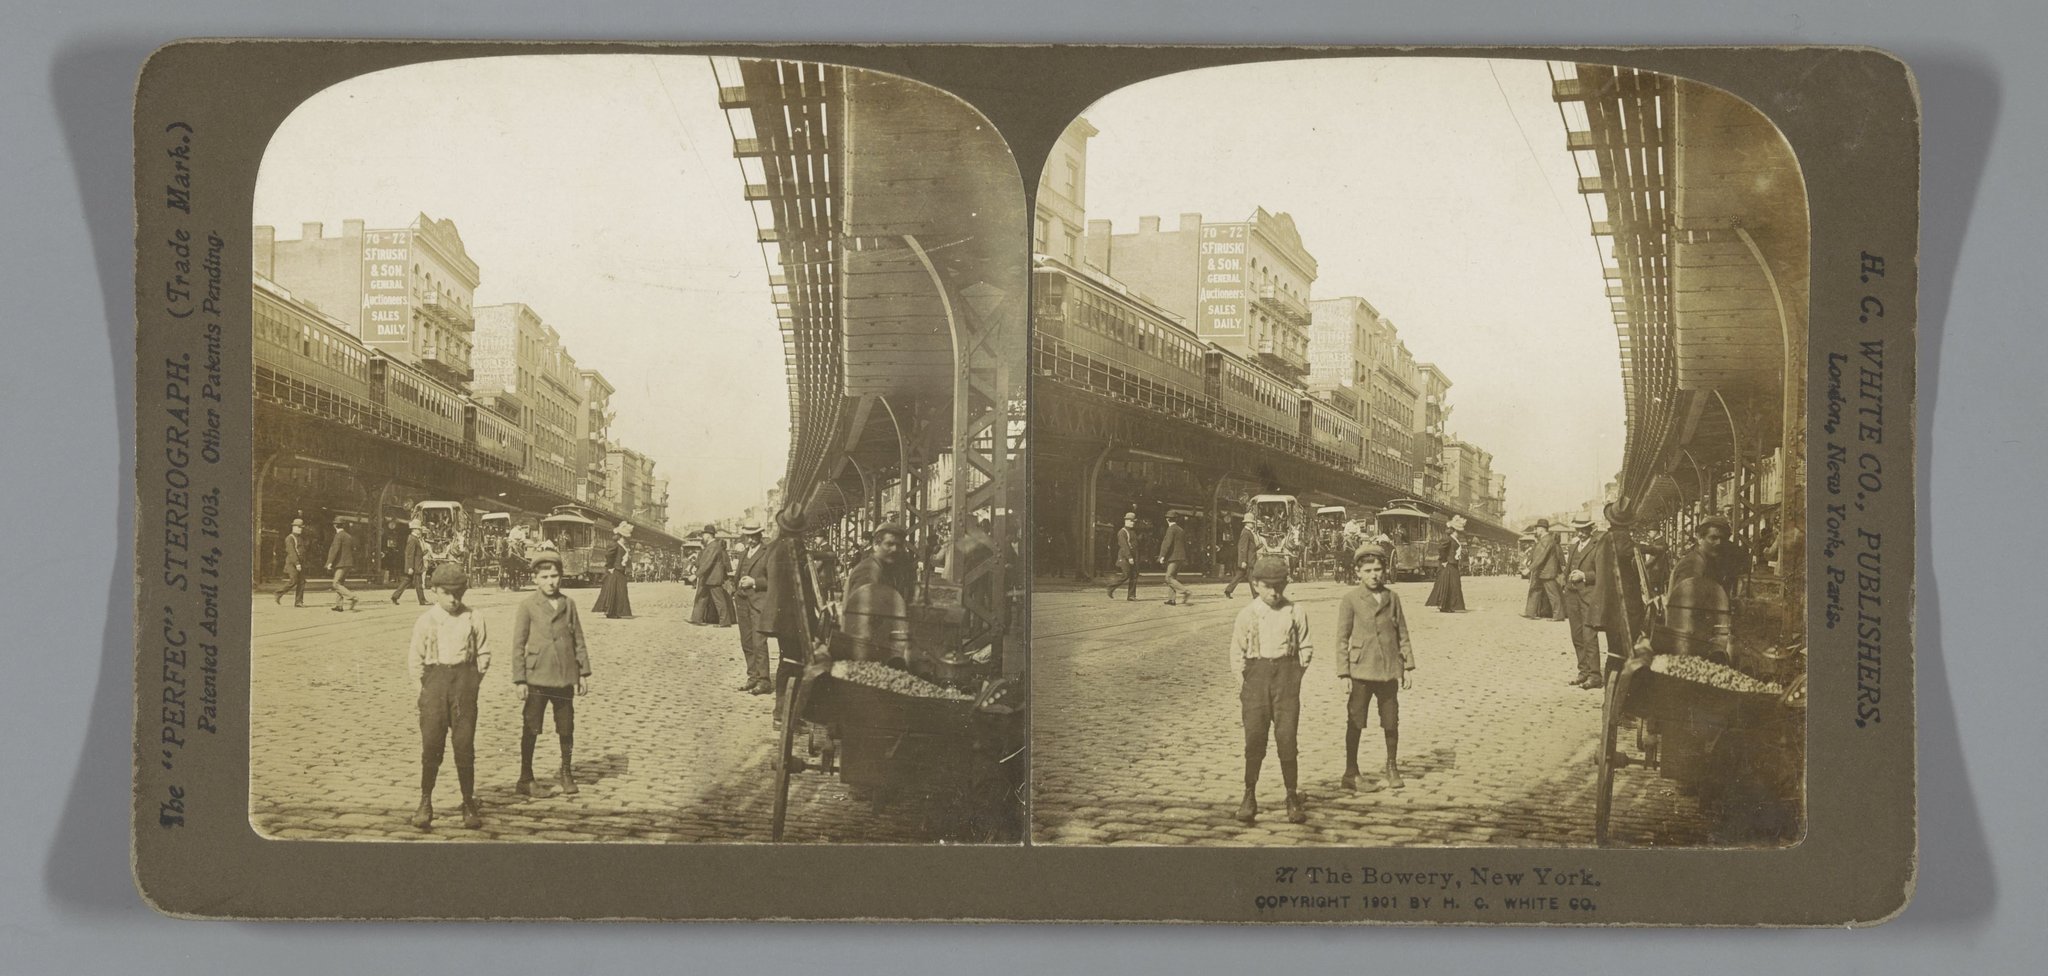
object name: stereograph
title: Bowery, New York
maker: Anonymous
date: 1901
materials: paper, cardboard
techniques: gelatin silver print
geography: new york city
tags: city-view in general; 'veduta', railway, train, new york (city)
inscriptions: number: ‘27’, inscription: ‘The " PERFEC" STEREOGRAPH. (Trade Mark.)/ Patented April 14, 1903. Other Patents Pending.’, copyright notice: ‘Copyright 1901 by H. C. White Co.’